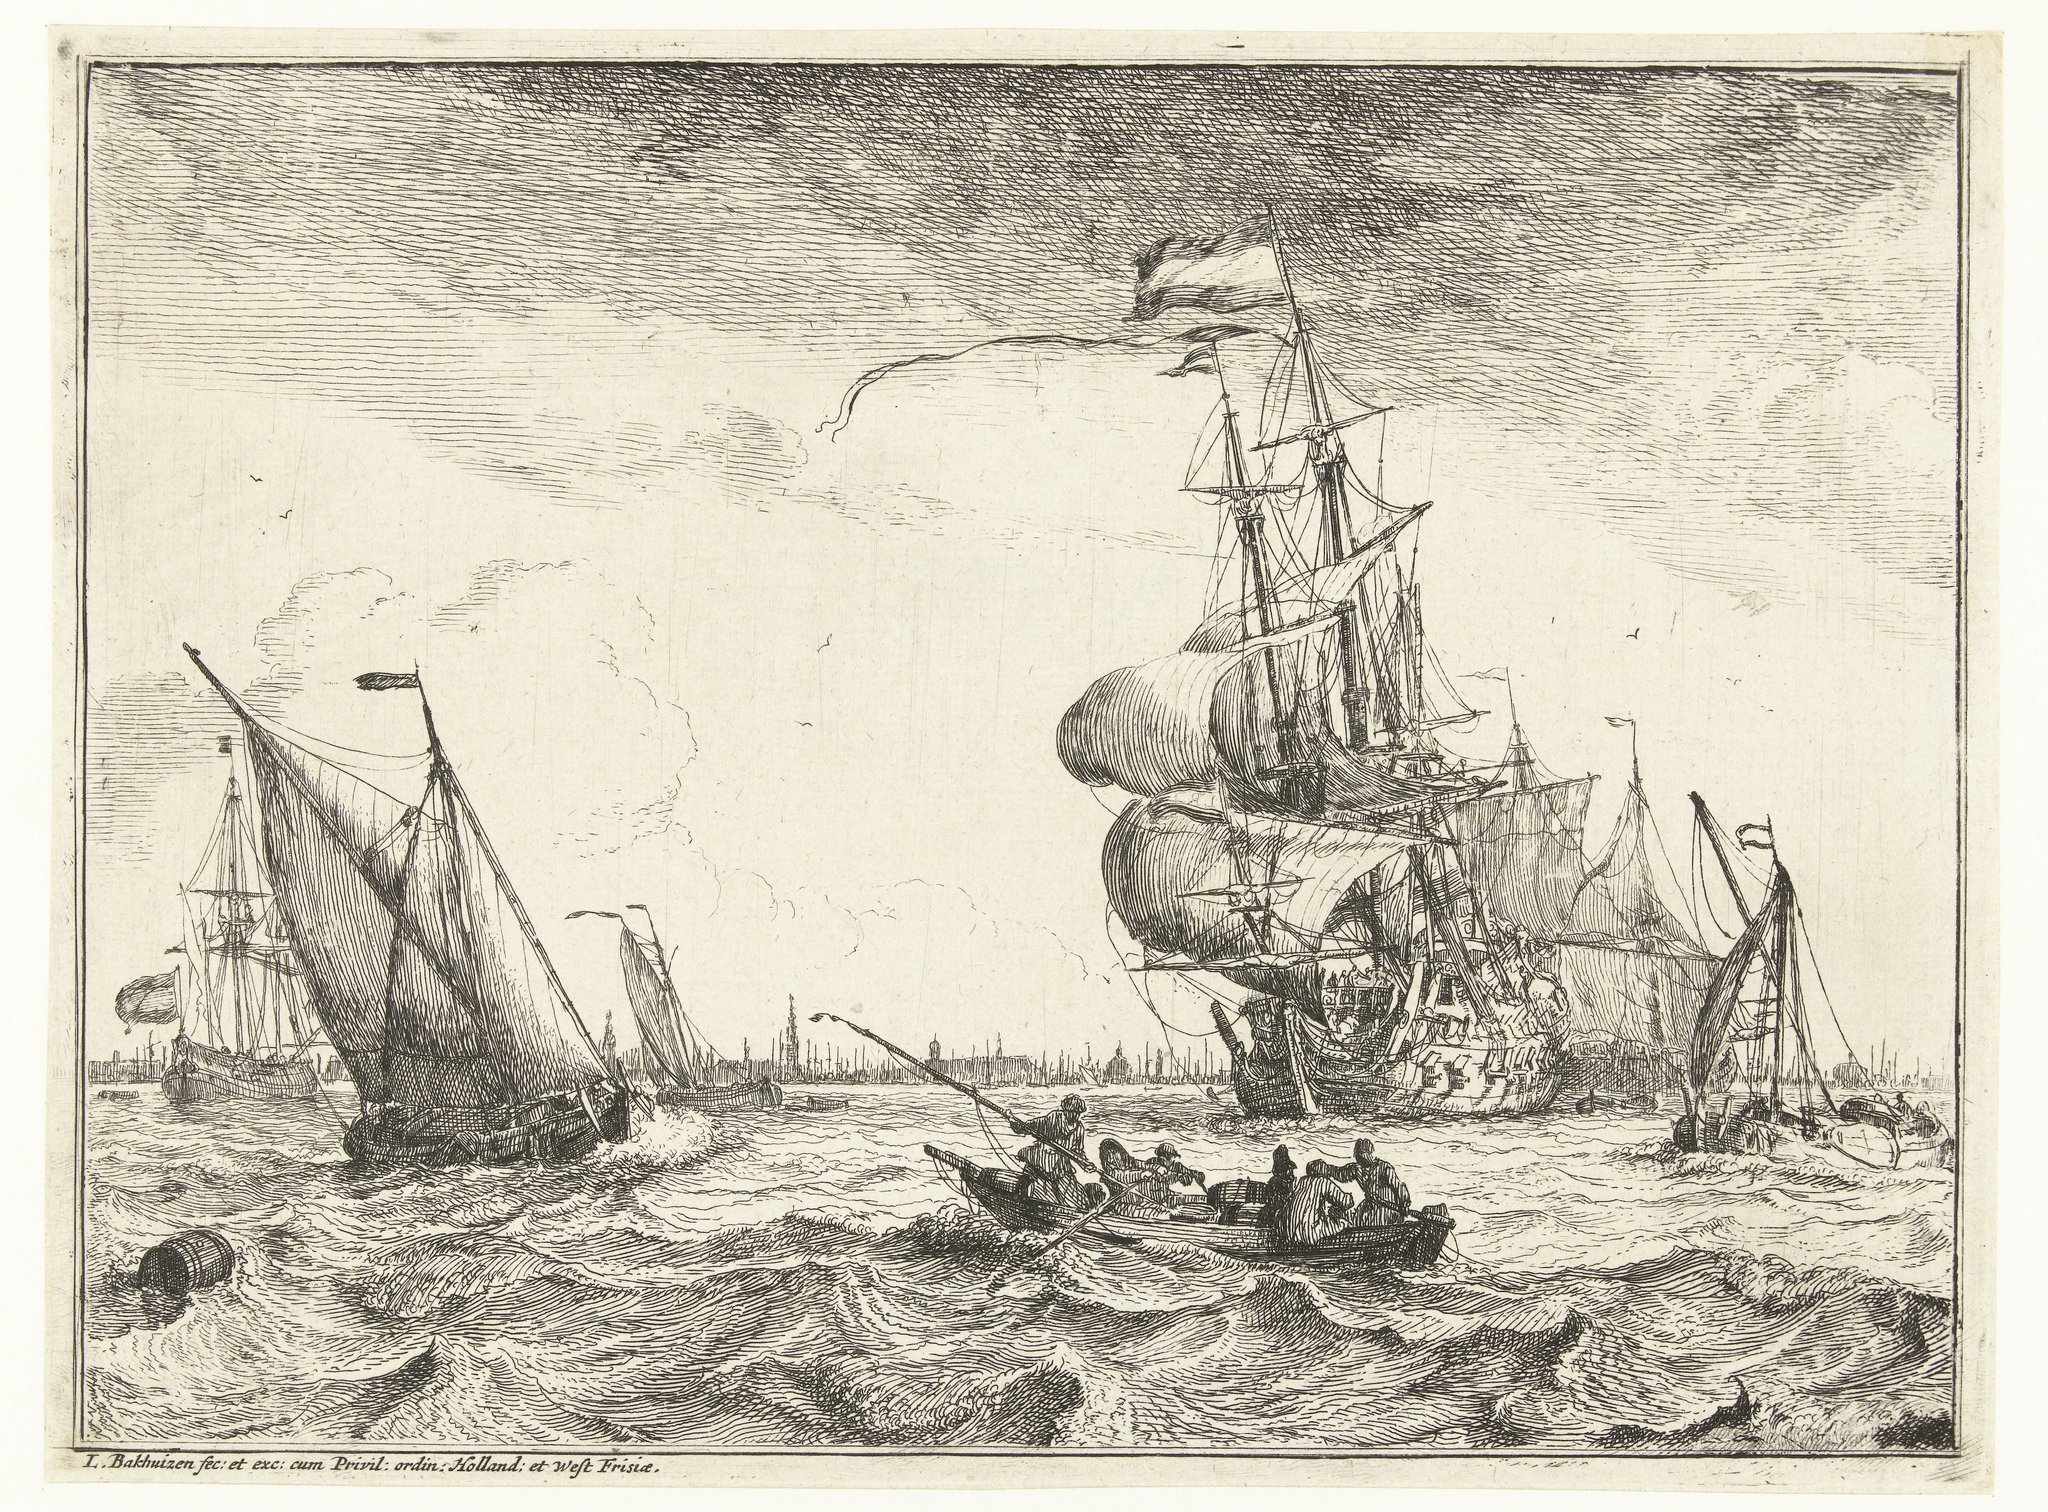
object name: print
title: Gezicht op het IJ met roeiboot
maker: ludolf bakhuysen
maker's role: draughtsman, print maker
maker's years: 1631-1708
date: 1701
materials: paper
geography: amsterdam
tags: sea (seascape)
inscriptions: inscription: ‘F Rechberger 1800’ Lugt 2133, collector's mark: Lugt 2228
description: Gezicht op het IJ in Amsterdam. Op de voorgrond een roeiboot met zes mannen, op de achtergrond grotere schepen. Prent uit een serie met tien zeegezichten.